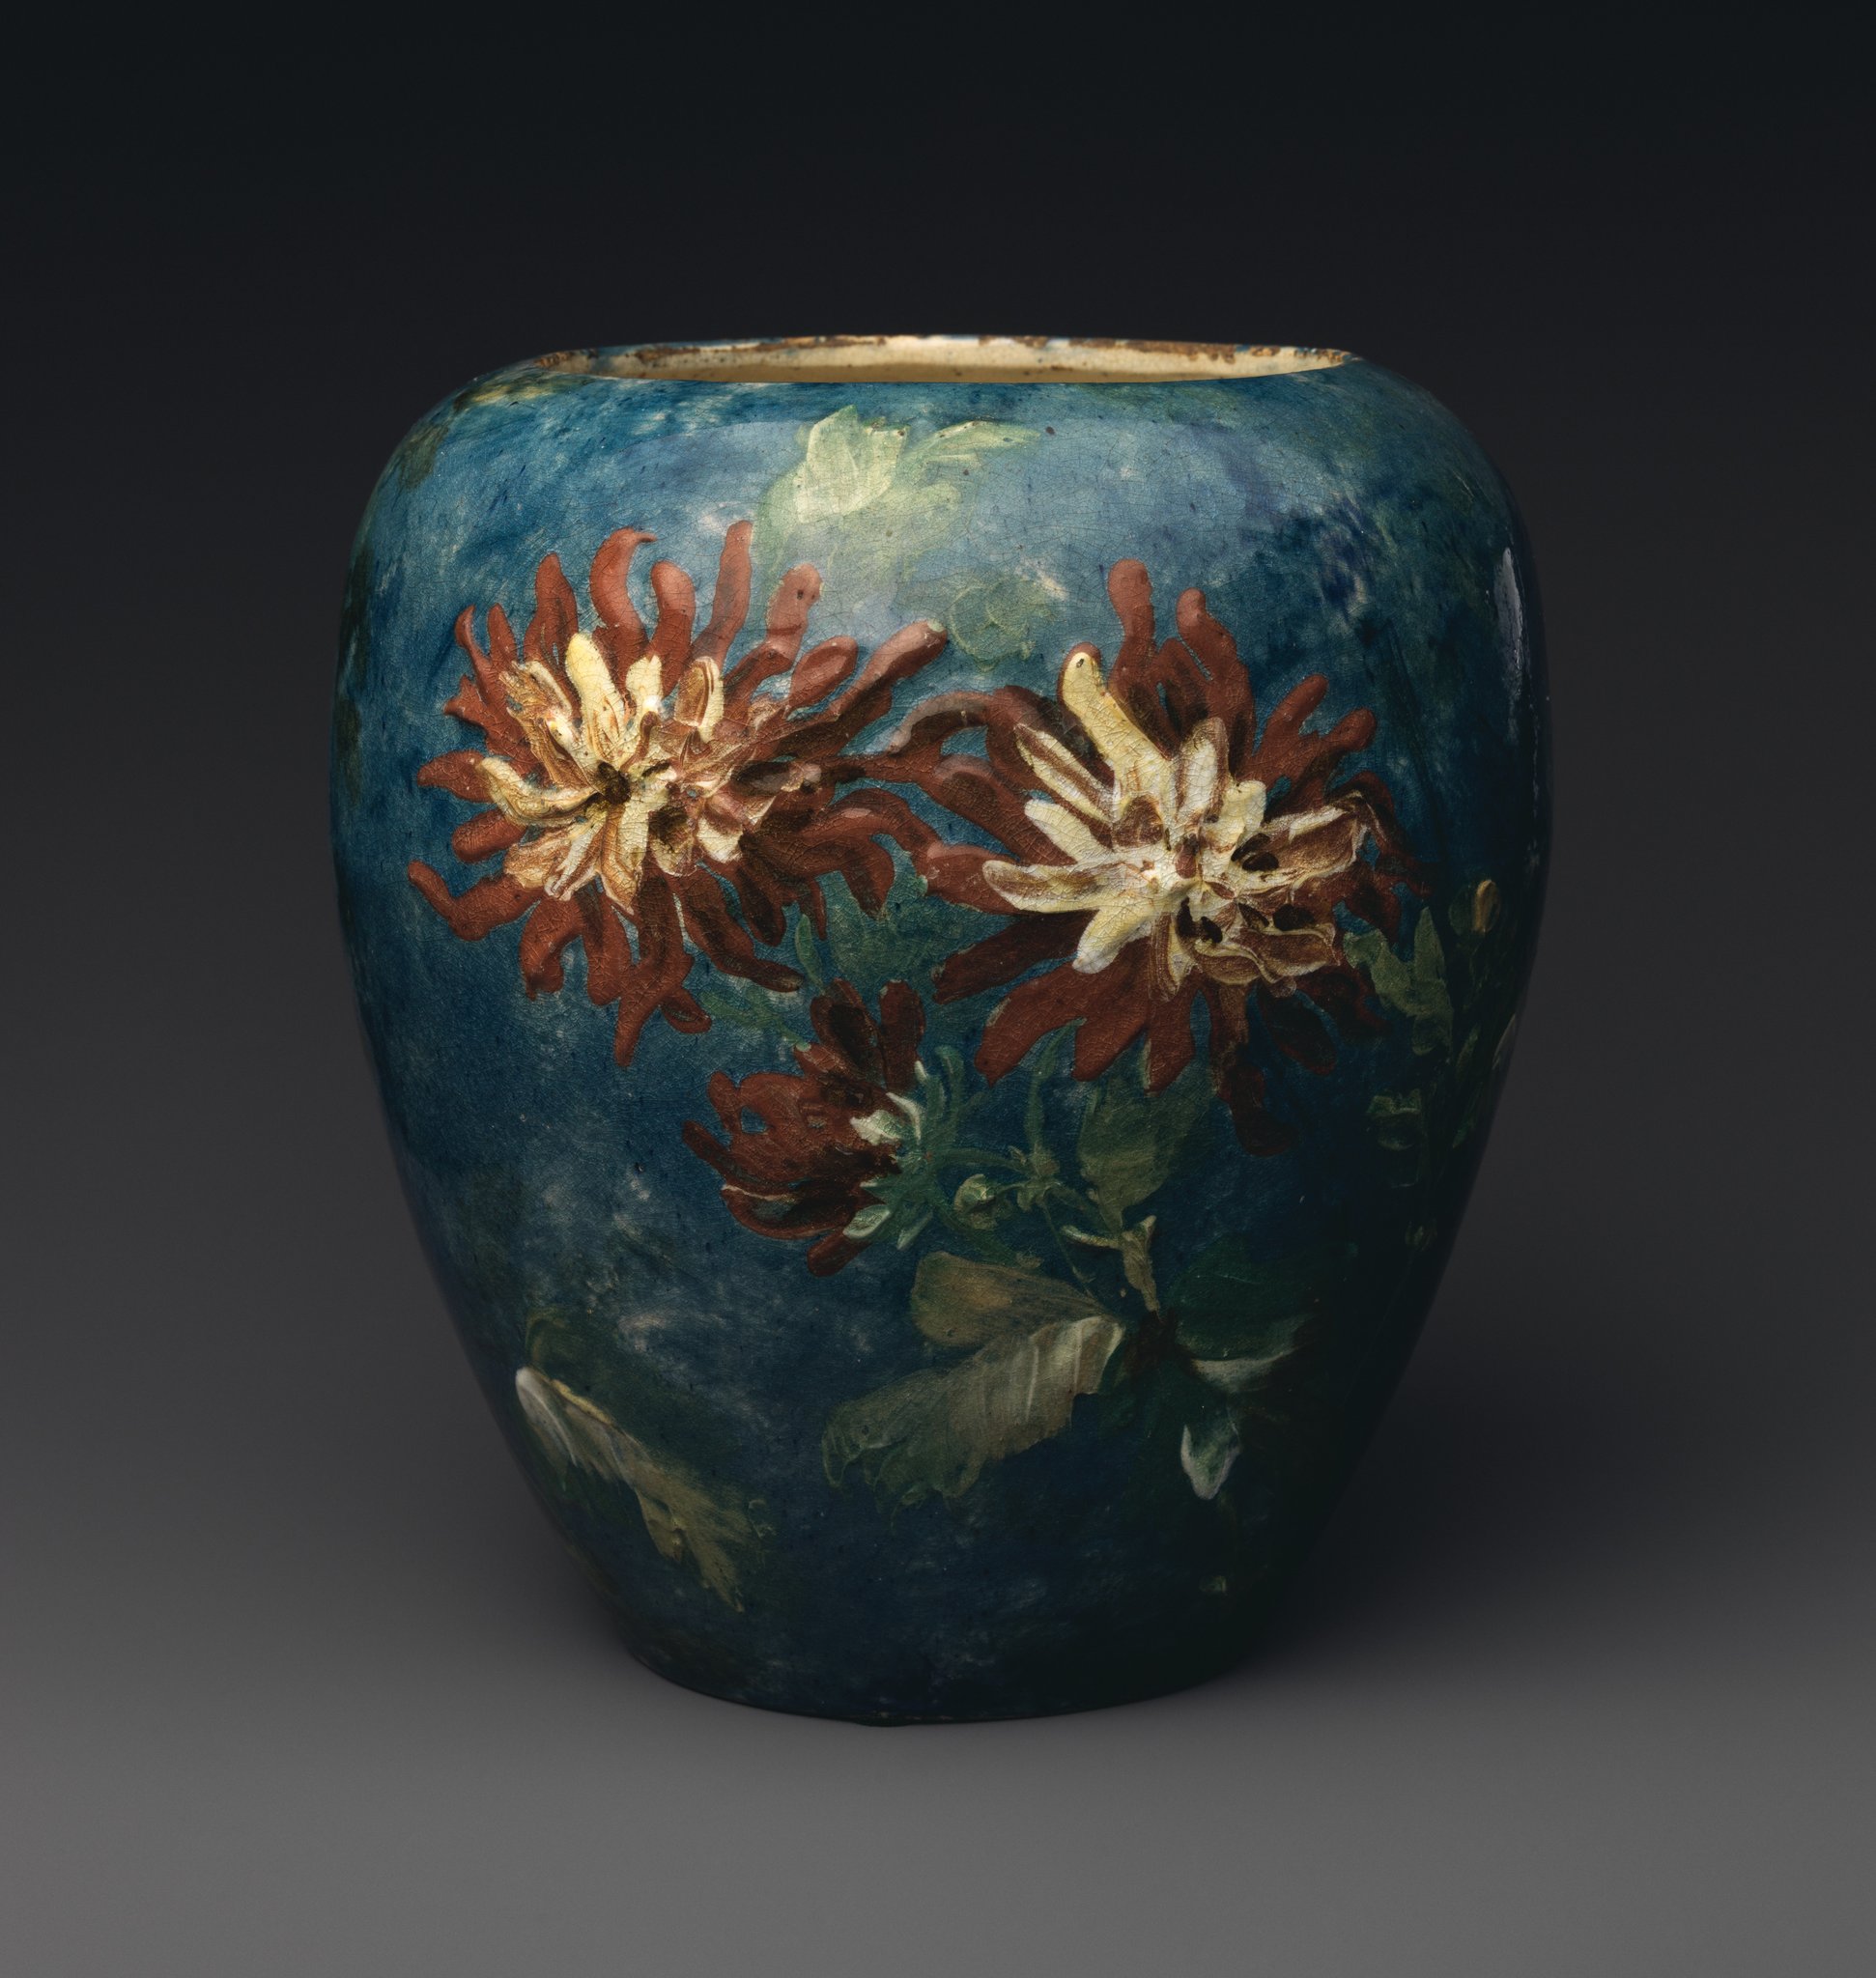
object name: vase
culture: american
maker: john bennett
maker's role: maker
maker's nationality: american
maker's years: 1840-1907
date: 1881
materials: earthenware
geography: united states